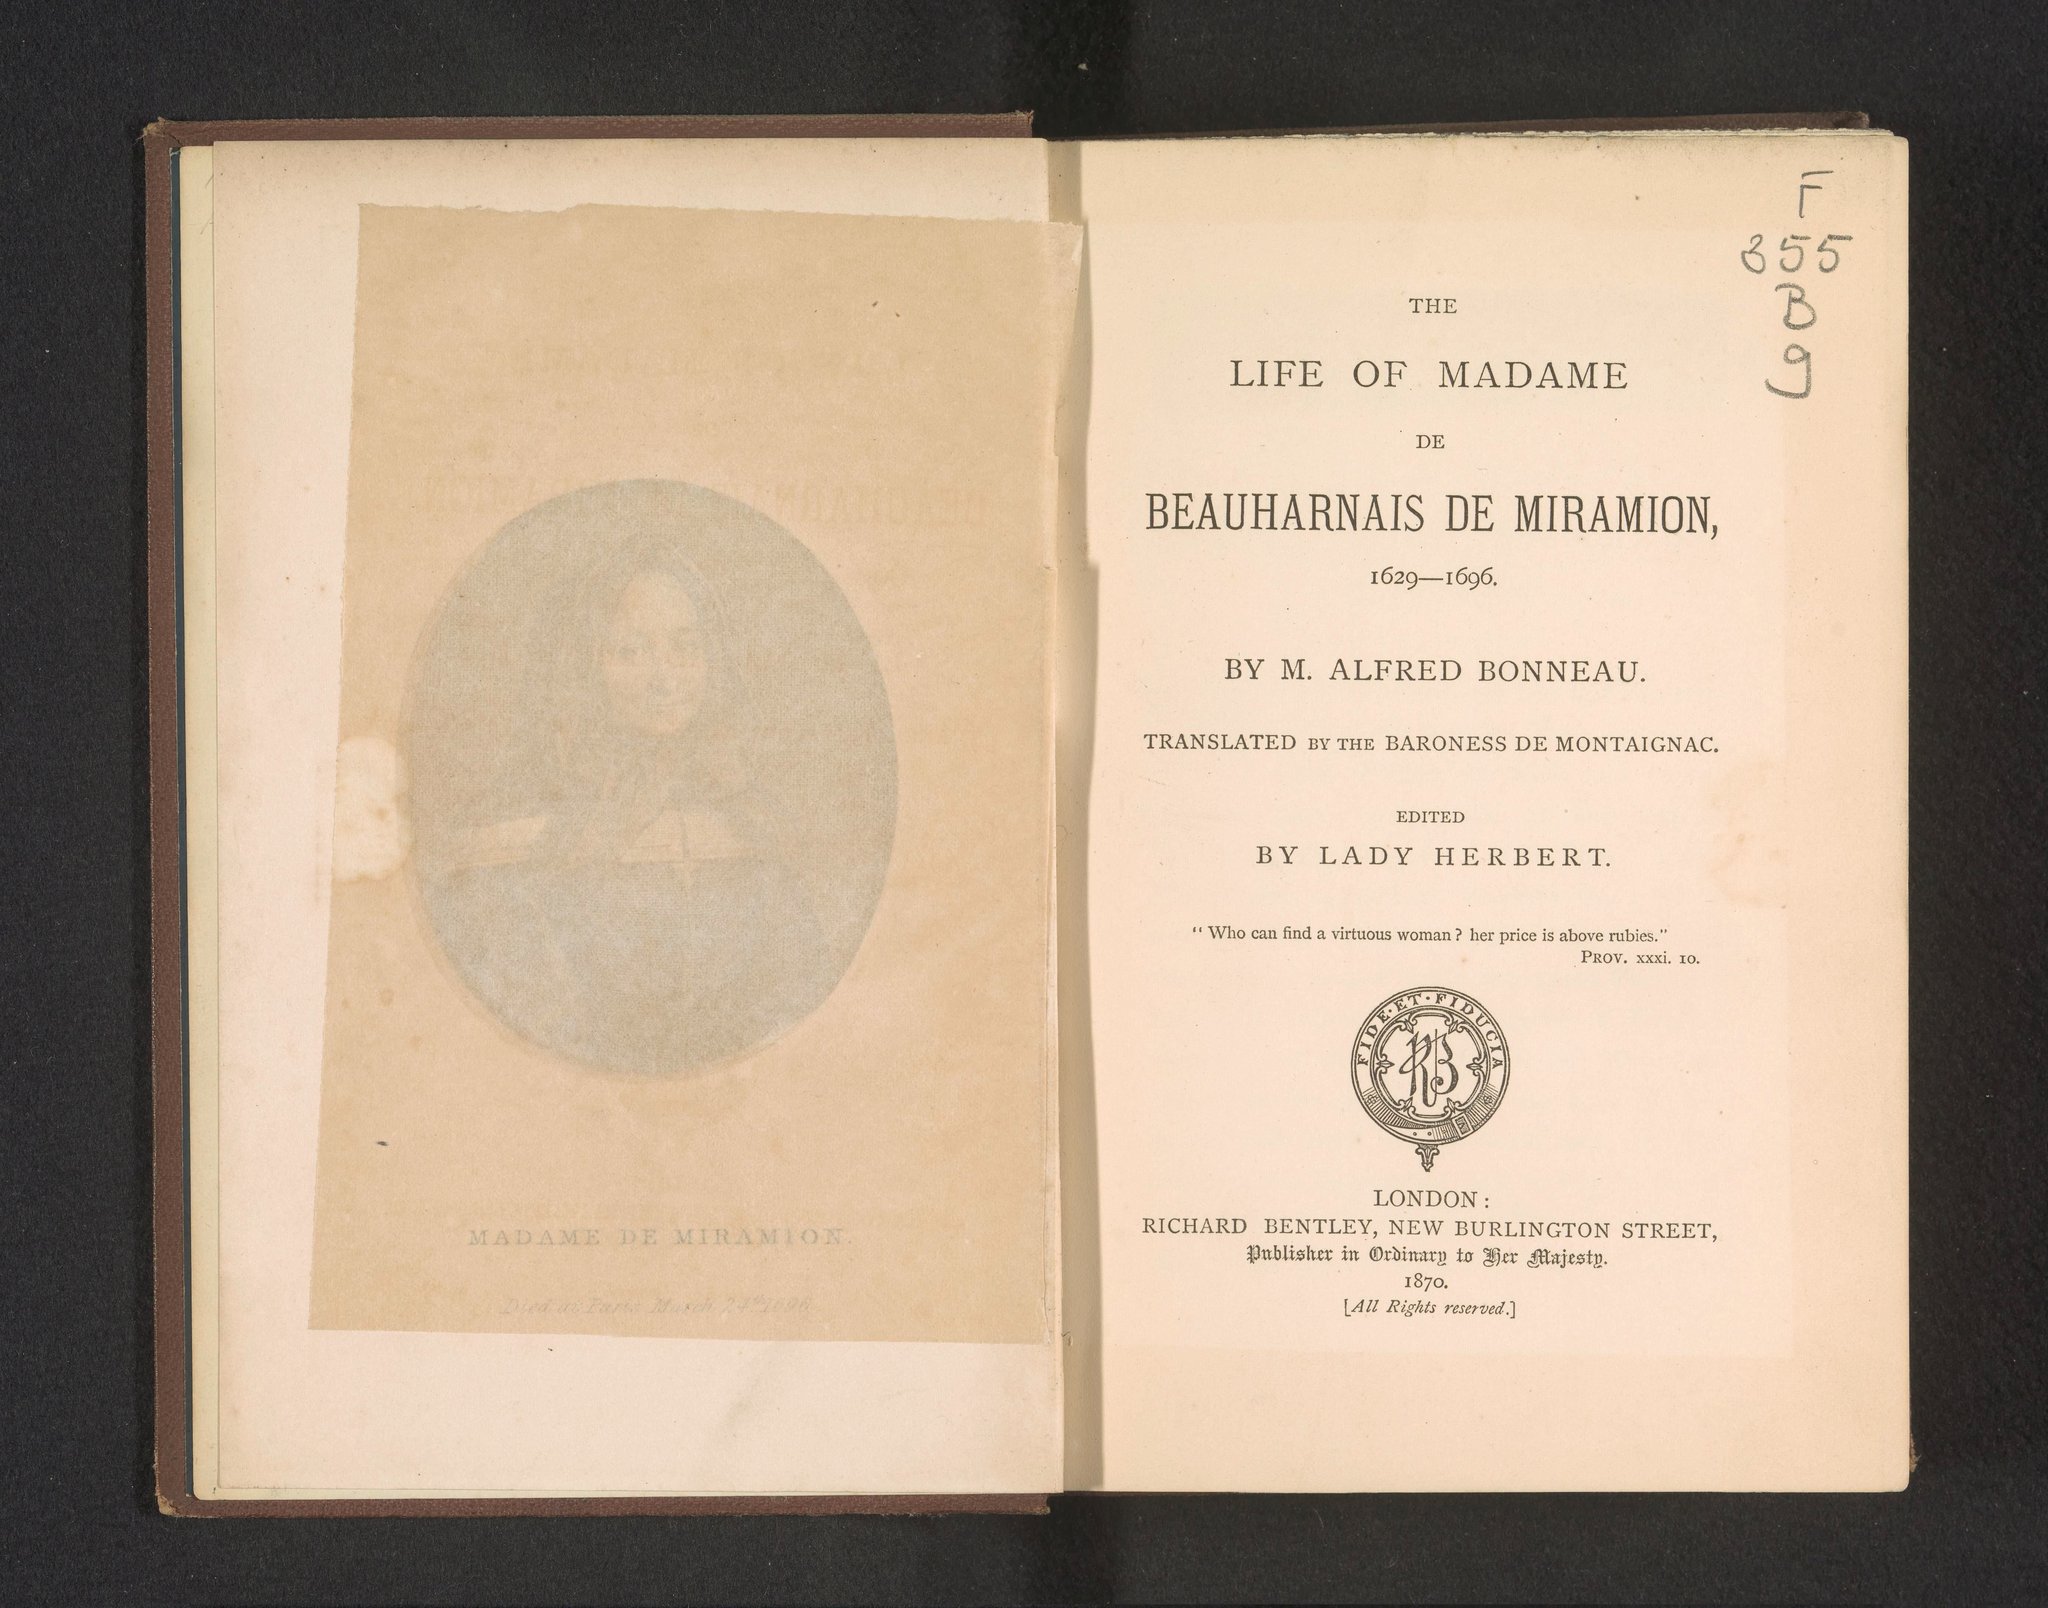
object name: book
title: The life of Madame de Beauharnais de Miramion 1629-1696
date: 1870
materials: cardboard, linen, paper, photographic support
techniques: albumen print, printing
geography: london